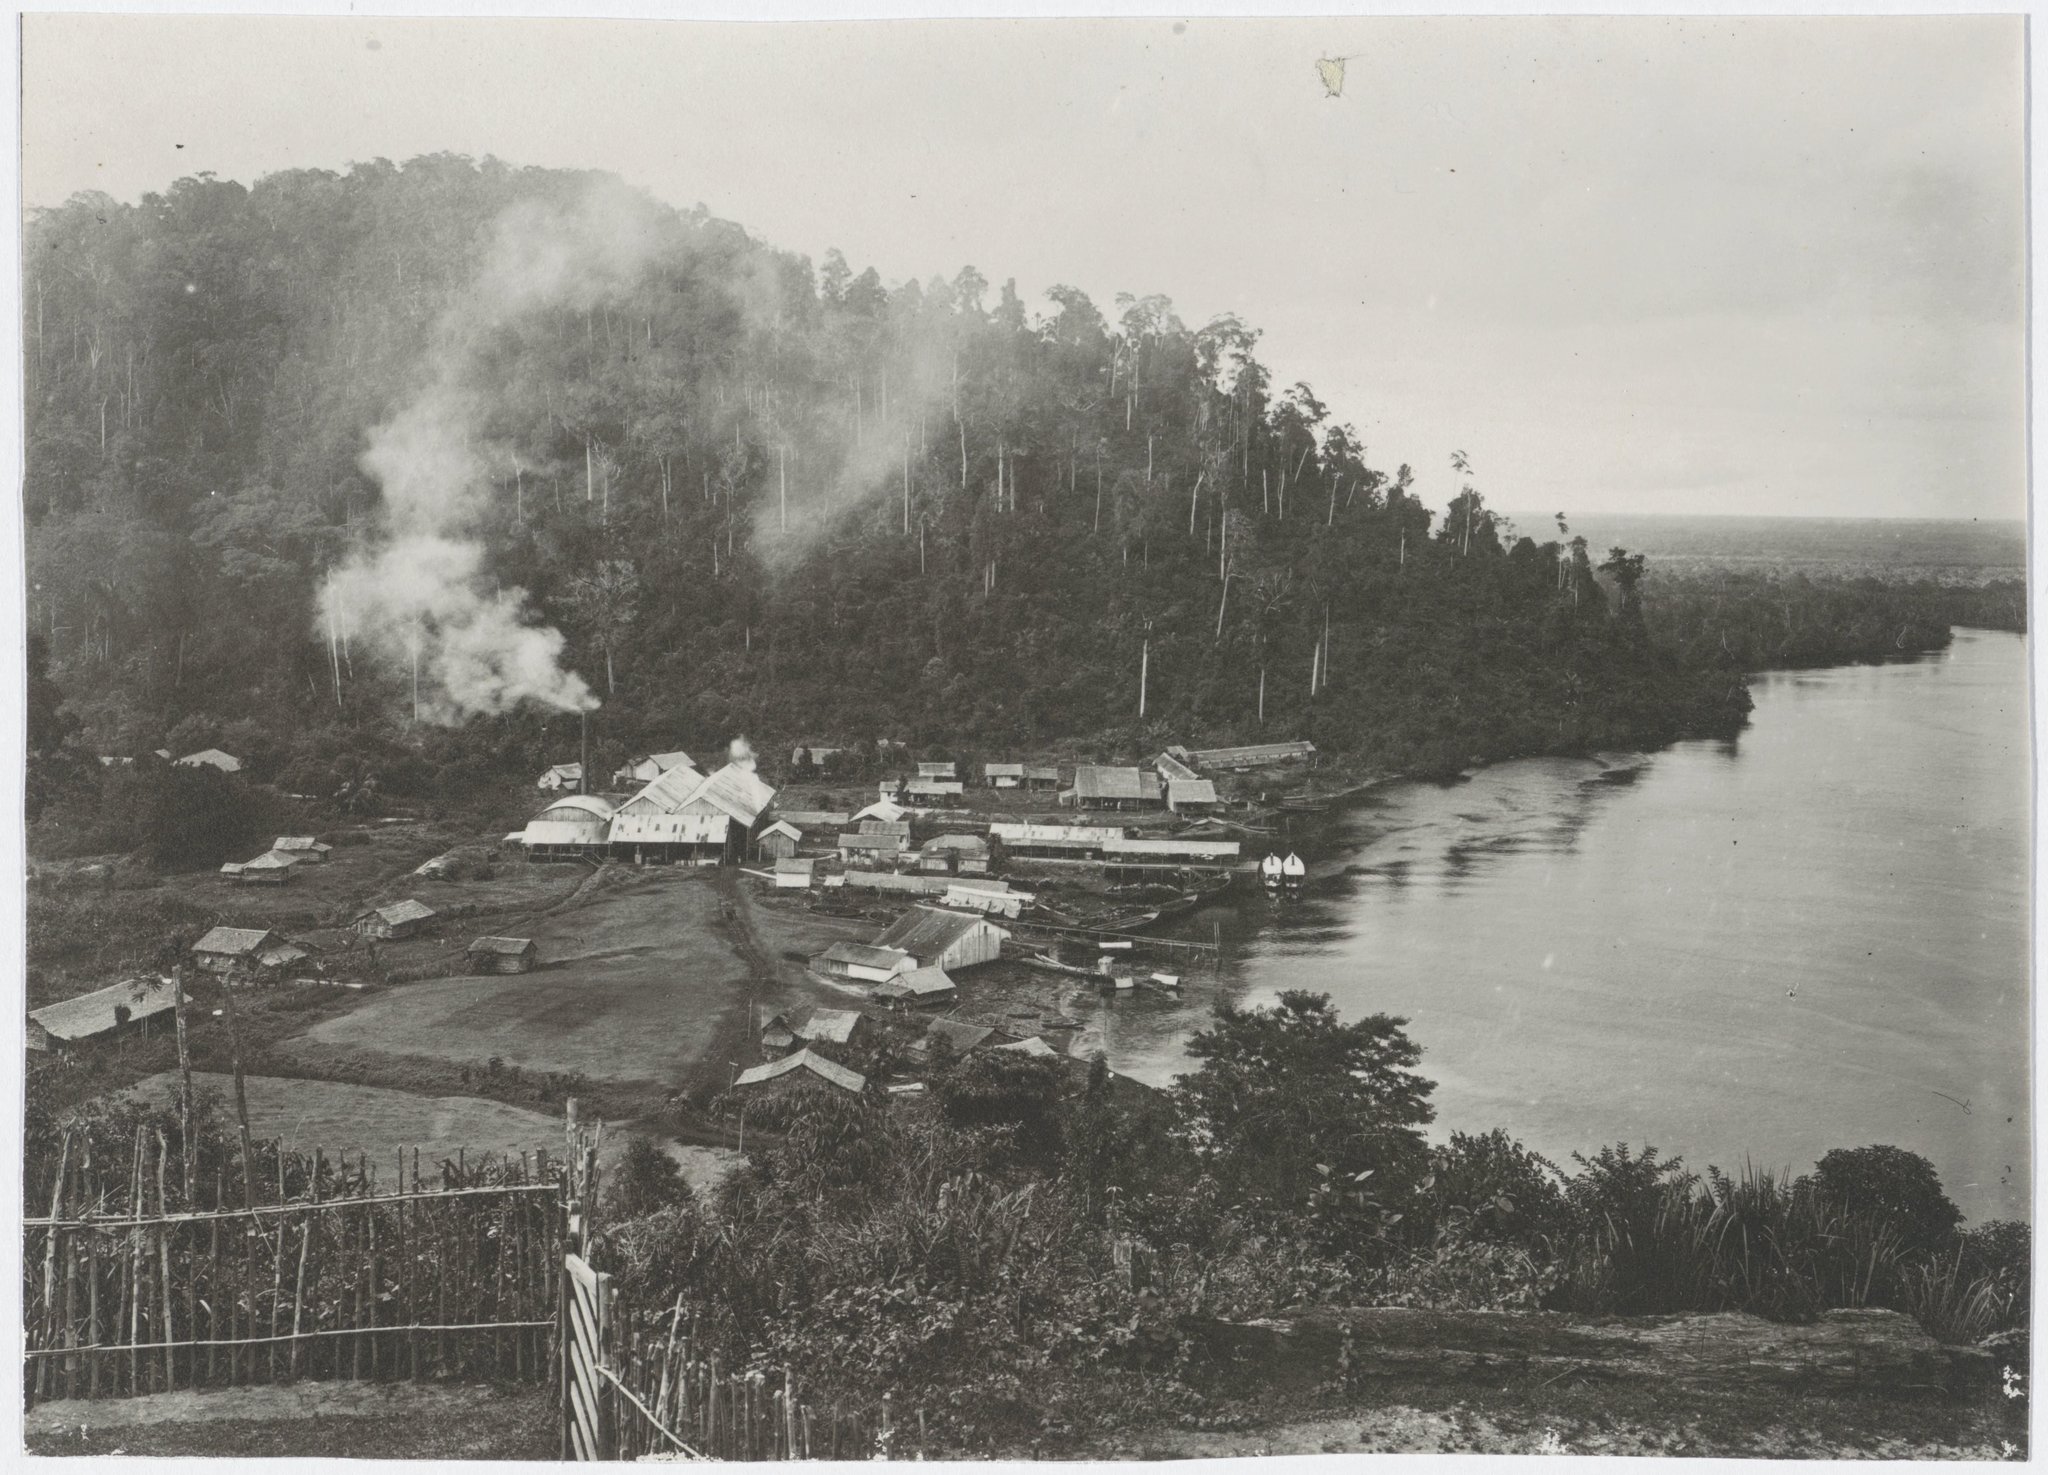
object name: photograph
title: Een fabriek in Telok, gelegen aan het water.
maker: johanna hermina marmelstein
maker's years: 1897-1990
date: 1900-1915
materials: paper, photographic support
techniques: albumen print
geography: jakarta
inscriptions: inscription: ‘Ingang van een aanzienlijk huis. Tempeltje, logis voor de huisgoden, stenen deurwachters.’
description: Een fabriek in Telok, gelegen aan het water. De fabriek heeft vele bijgebouwen en enkele aangemeerde boten.